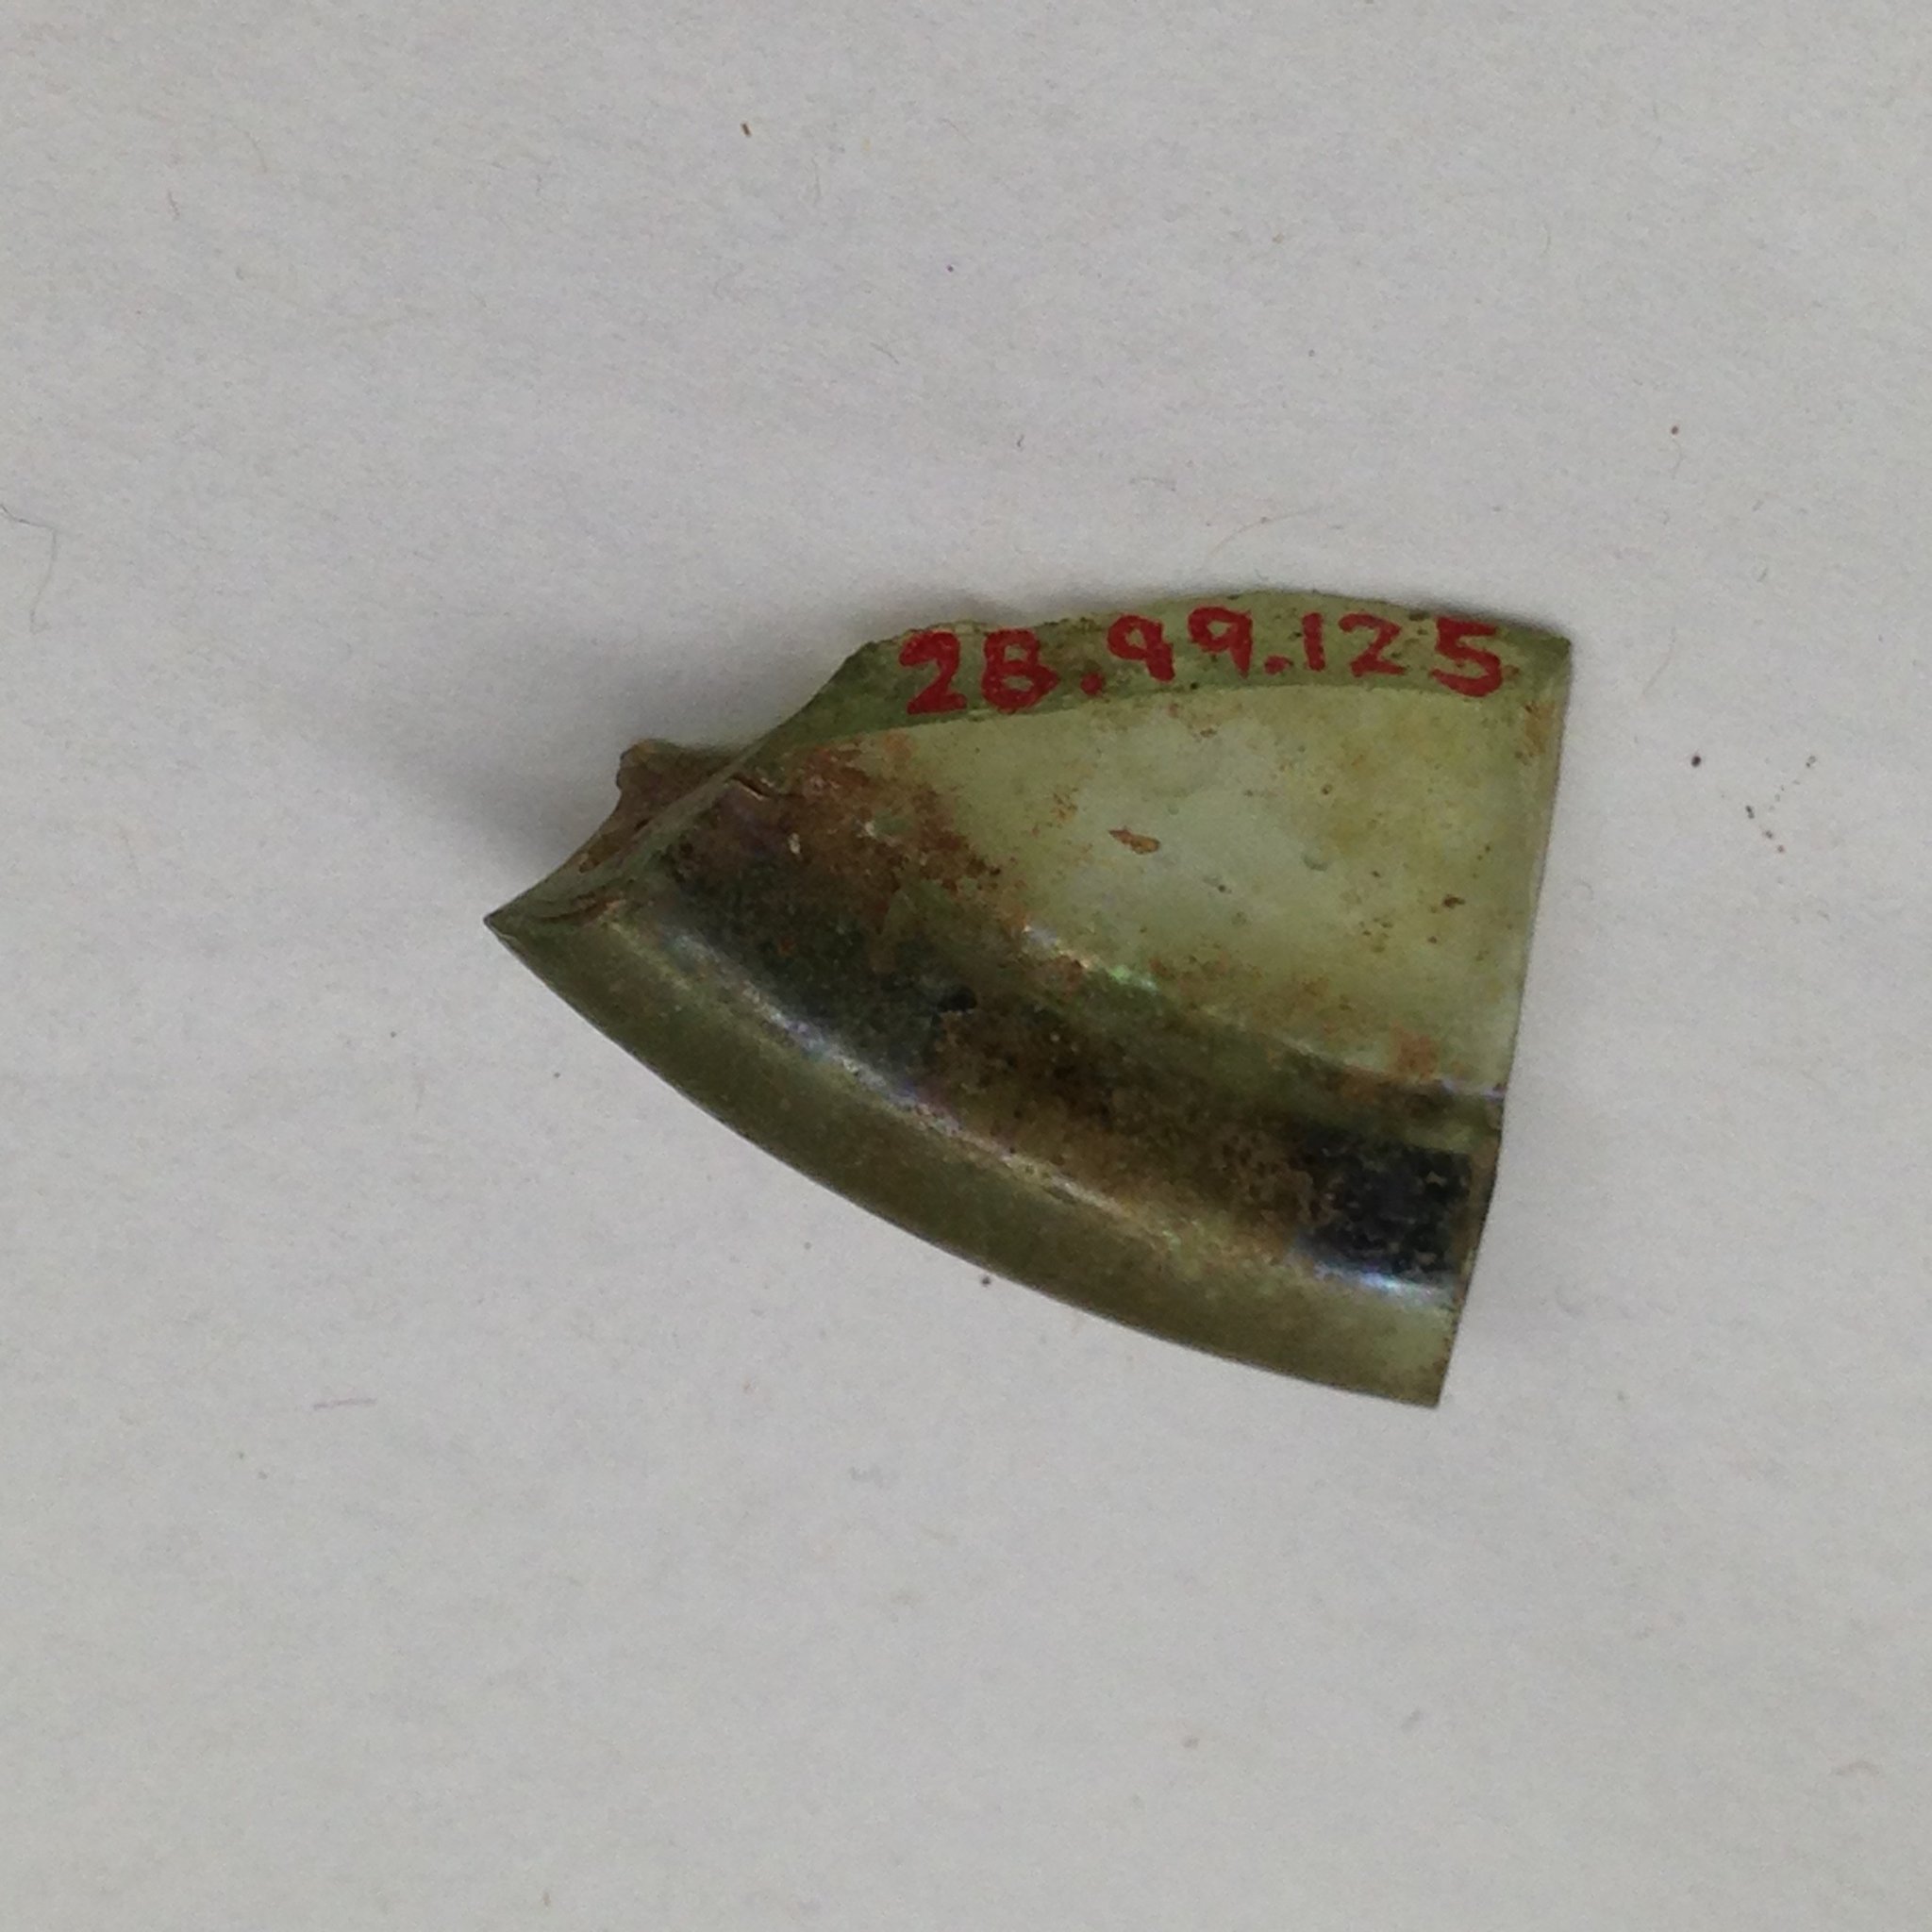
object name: fragment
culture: european or middle eastern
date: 1150-1250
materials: ceramic, glass